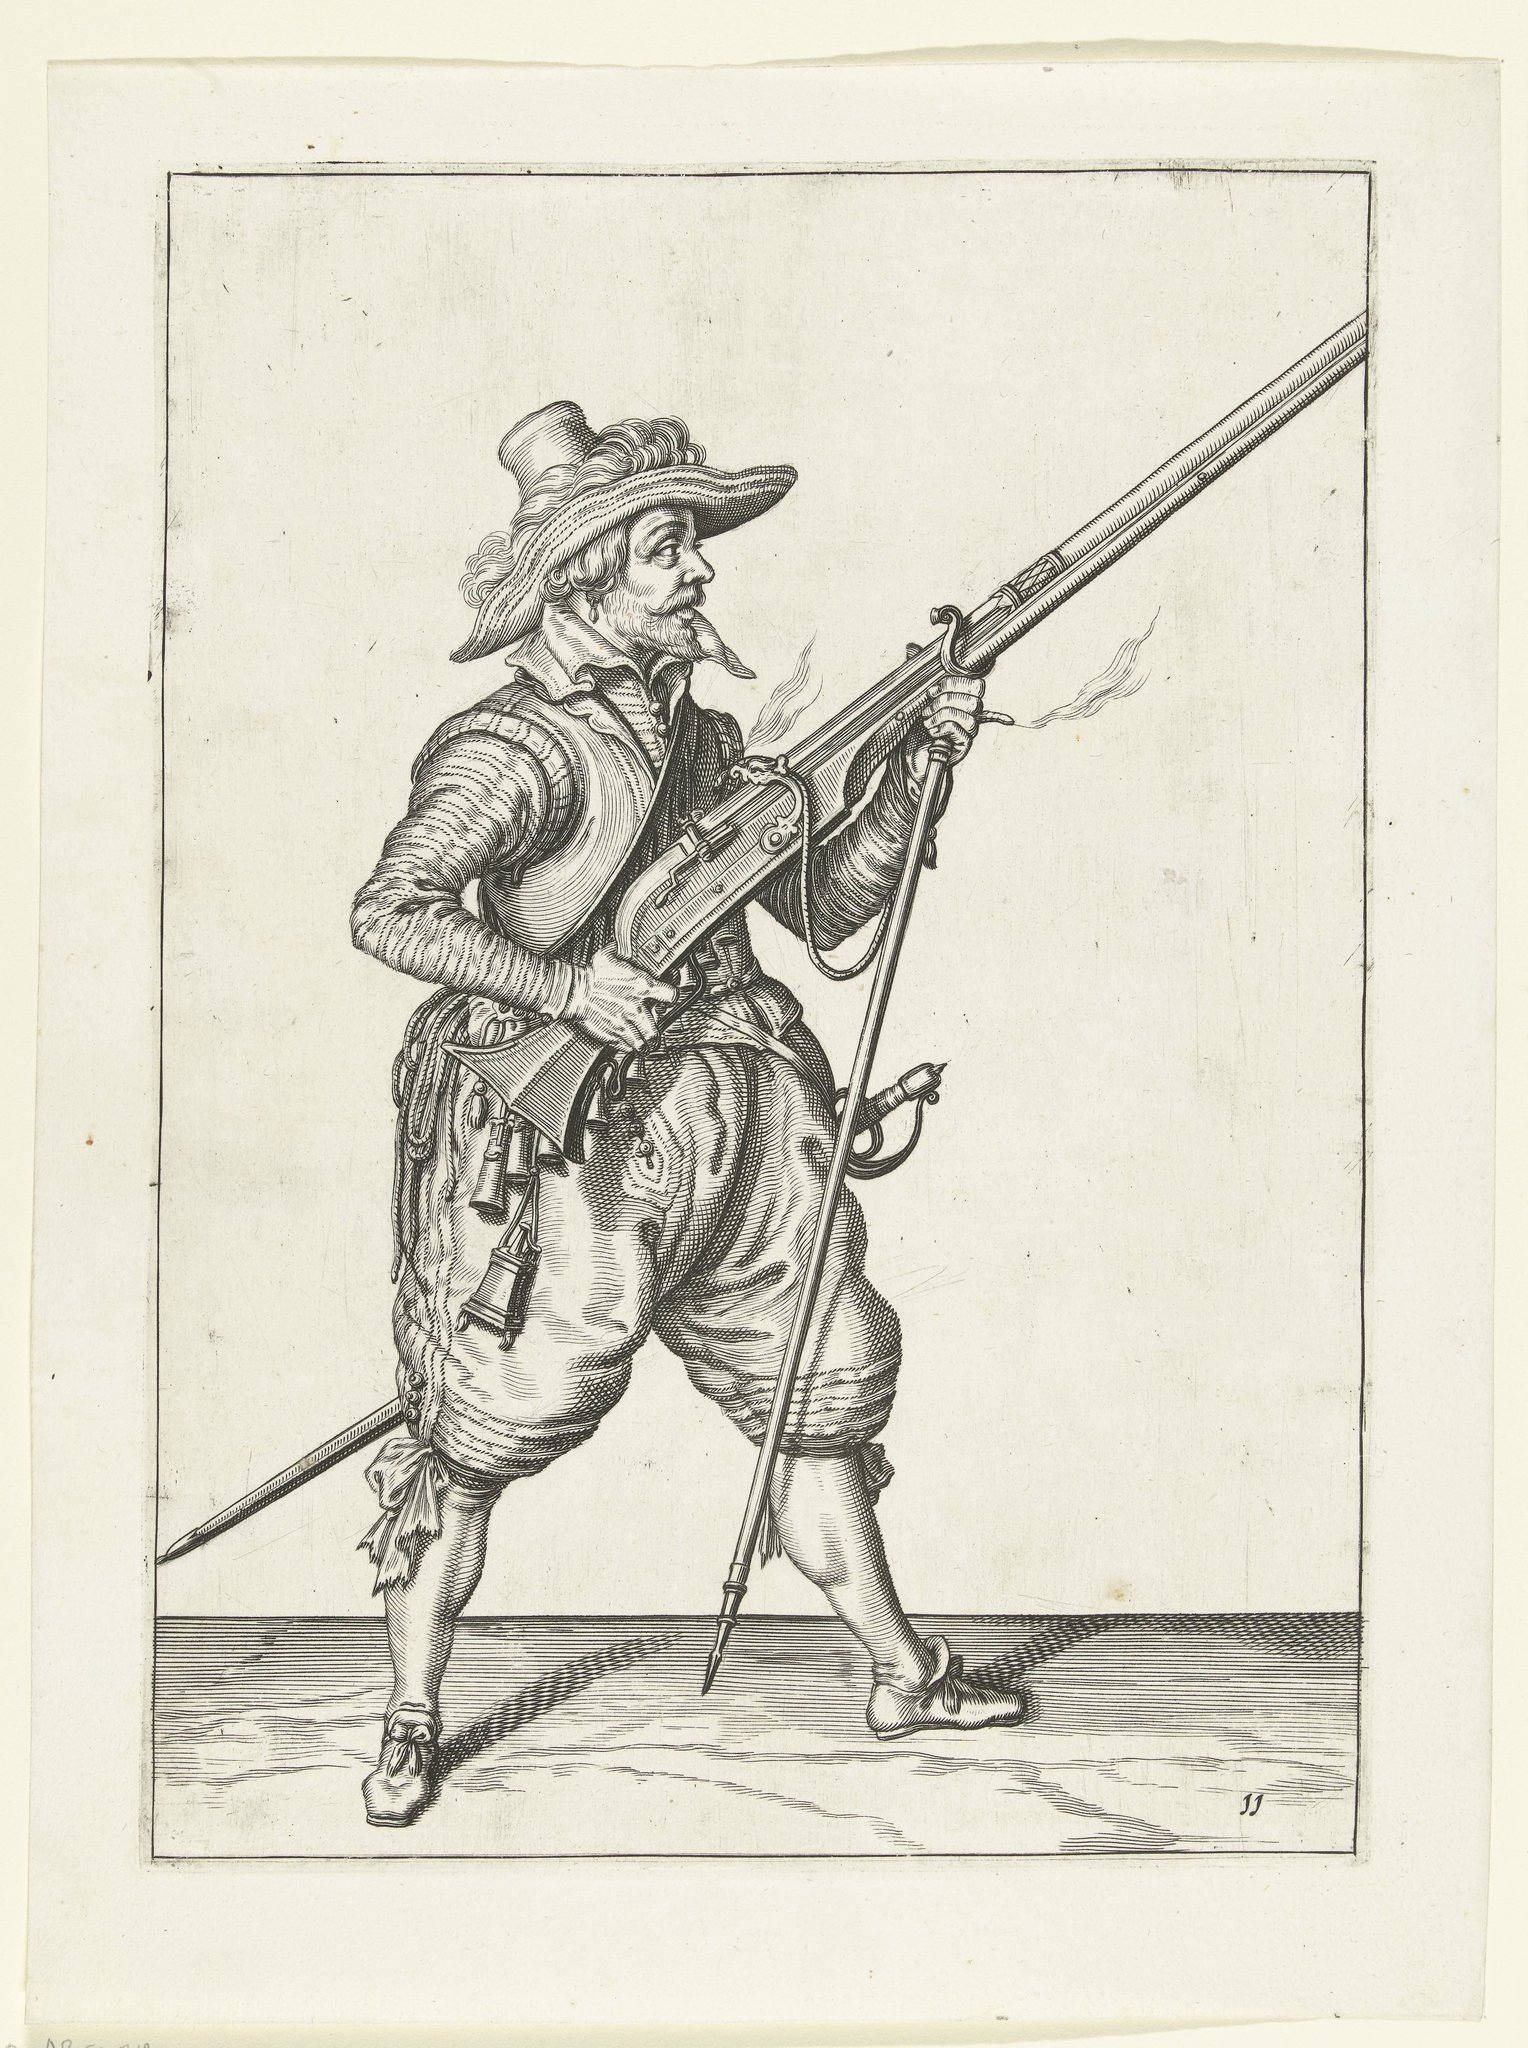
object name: print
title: Wapenhandelinghe van Roers Musquetten ende Spiessen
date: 1597-1607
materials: paper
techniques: engraving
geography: netherlands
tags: manoeuvre ~ military training, firearms: rifle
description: Een soldaat, ten voeten uit, naar rechts, die een musket (een bepaald type vuurwapen) met de rechterhand schuin omhoog gericht vasthoudt, terwijl hij een furket (musketvork) onder de loop plaatst. Deze prent is onderdeel van de reeks van 43 genummerde prenten van musketiers uit de Wapenhandelinghe.